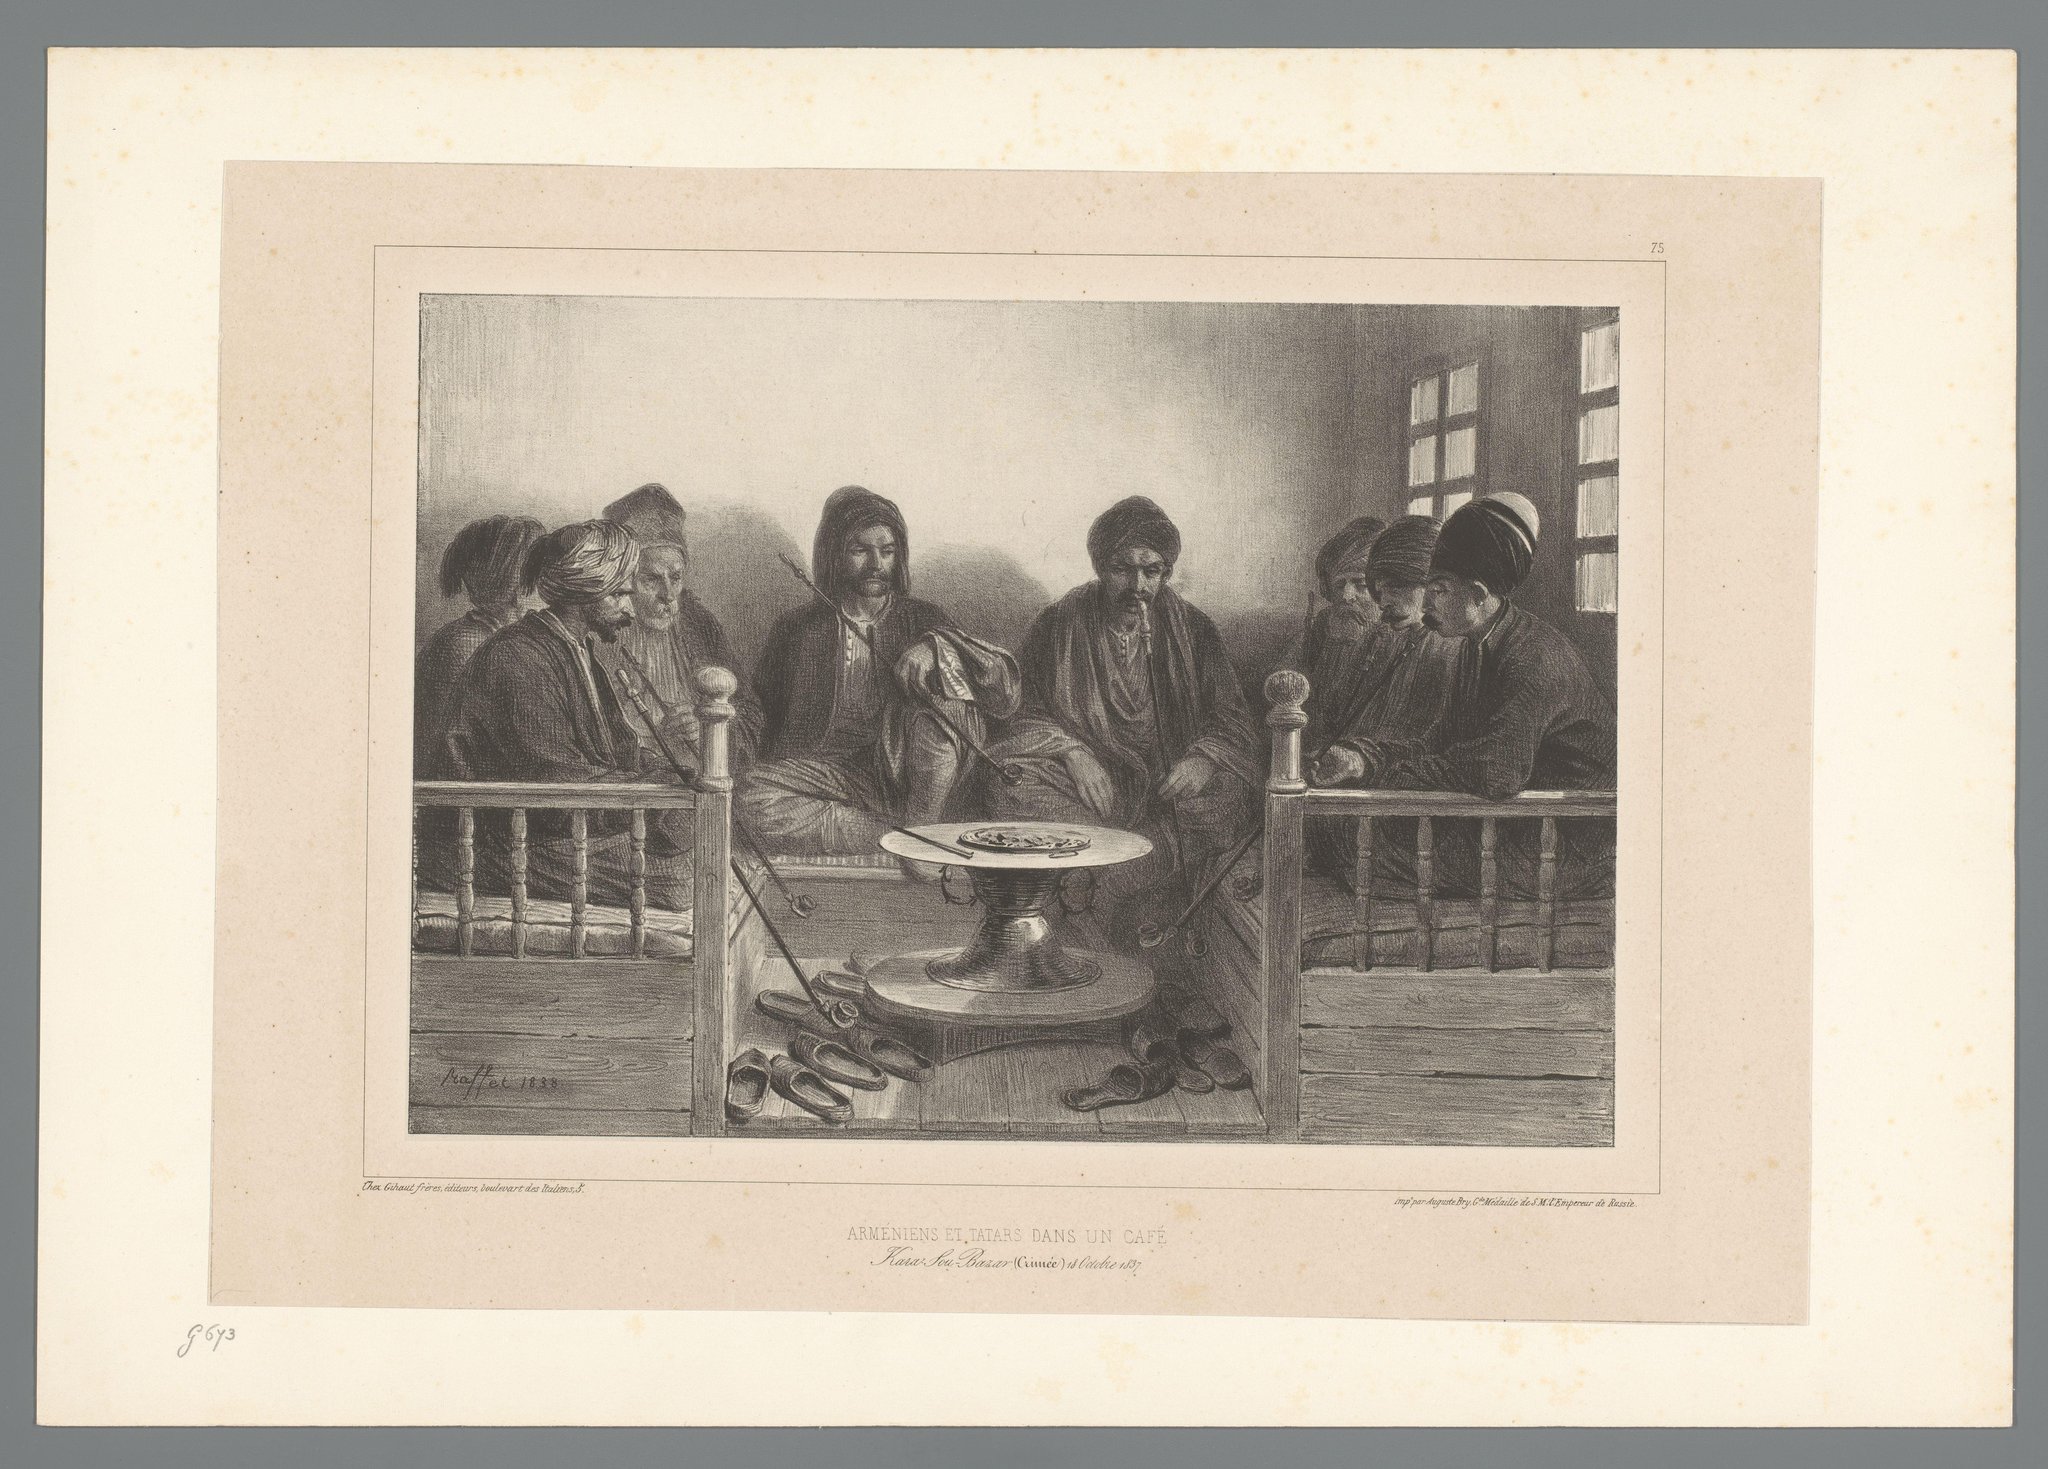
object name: print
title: Arméniens et Tatars dans un café (...) 18 octobre 1837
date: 1838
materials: paper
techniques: lithograph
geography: paris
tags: fashion, clothing, adult man, pipe ~ tobacco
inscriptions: collector's mark: Lugt 964